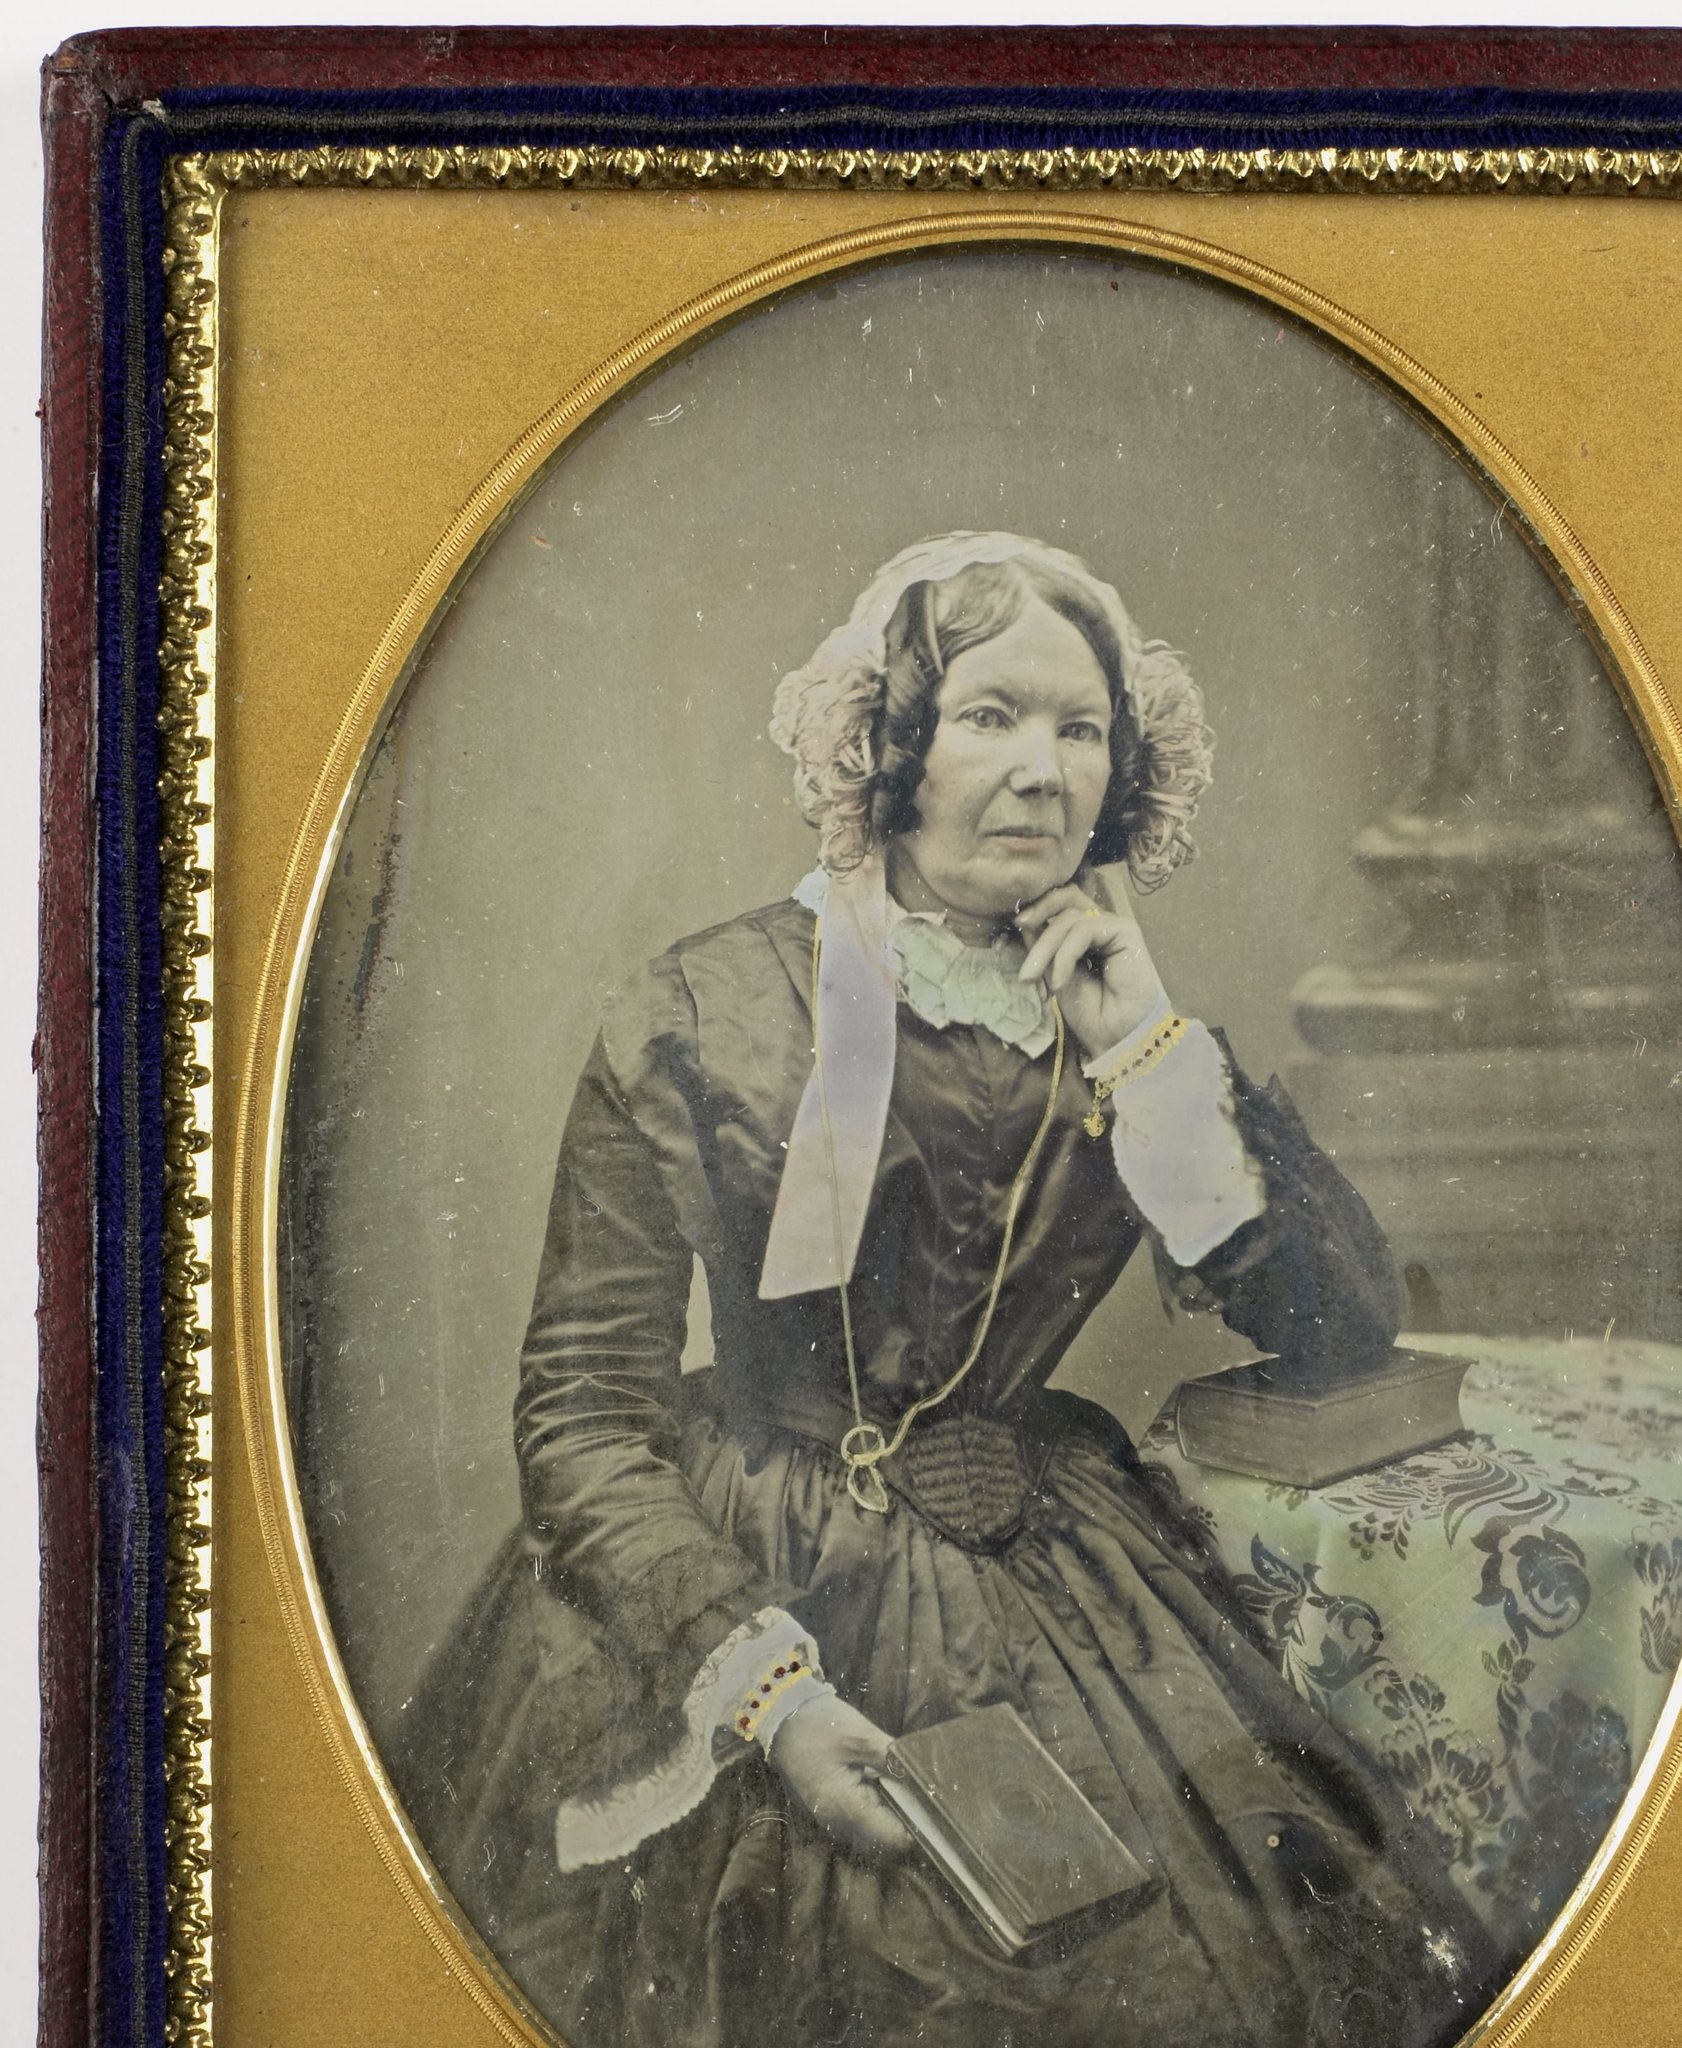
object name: photograph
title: Portret van een onbekende vrouw met boek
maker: edwin fehrenbach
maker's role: fotograaf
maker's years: 1848-1888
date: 1840-1860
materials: copper, glass, leather, velvet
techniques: daguerreotype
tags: adult woman, historical persons, book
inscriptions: inscription: ‘E. Fehrenbach/ Artist/ 111 Strand’